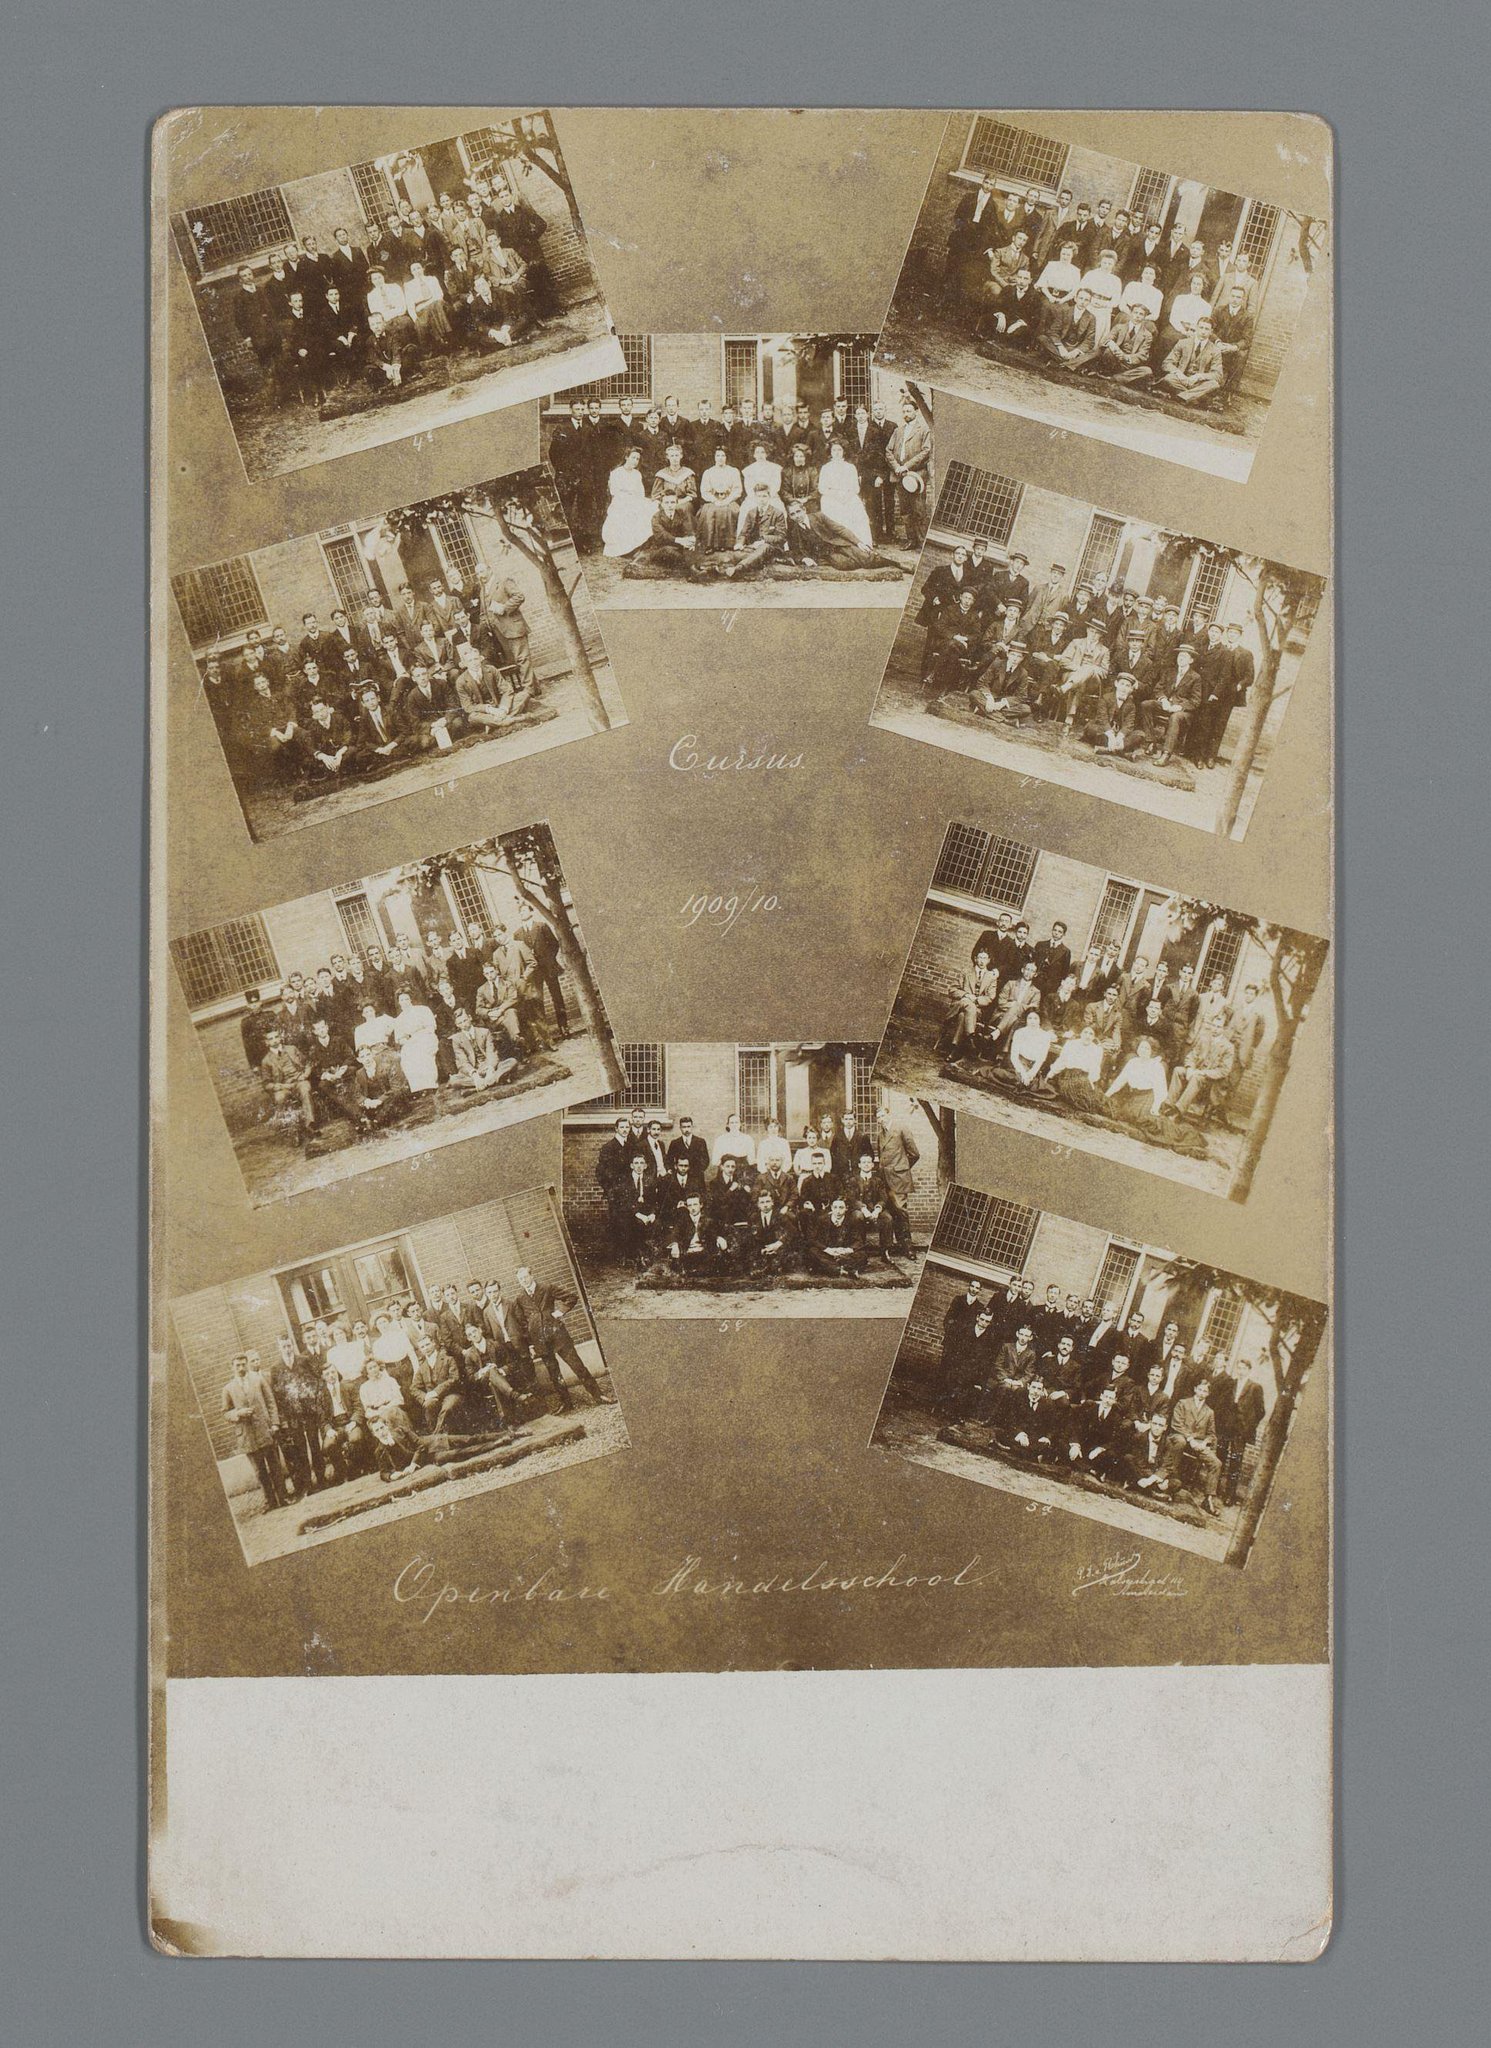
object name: ansichtkaart, prentbriefkaart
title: Cursus 1909/1910 Openbare Handelsschool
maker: p.d. van rhijn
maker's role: fotograaf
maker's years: 1874-1942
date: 1910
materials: paper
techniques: gelatin silver print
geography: amsterdam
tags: education, anonymous historical persons portrayed in a group, in a group-portrait, amsterdam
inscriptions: address: ‘P.D. v Rhijn/ Kalverstraat 114/ Amsterdam’